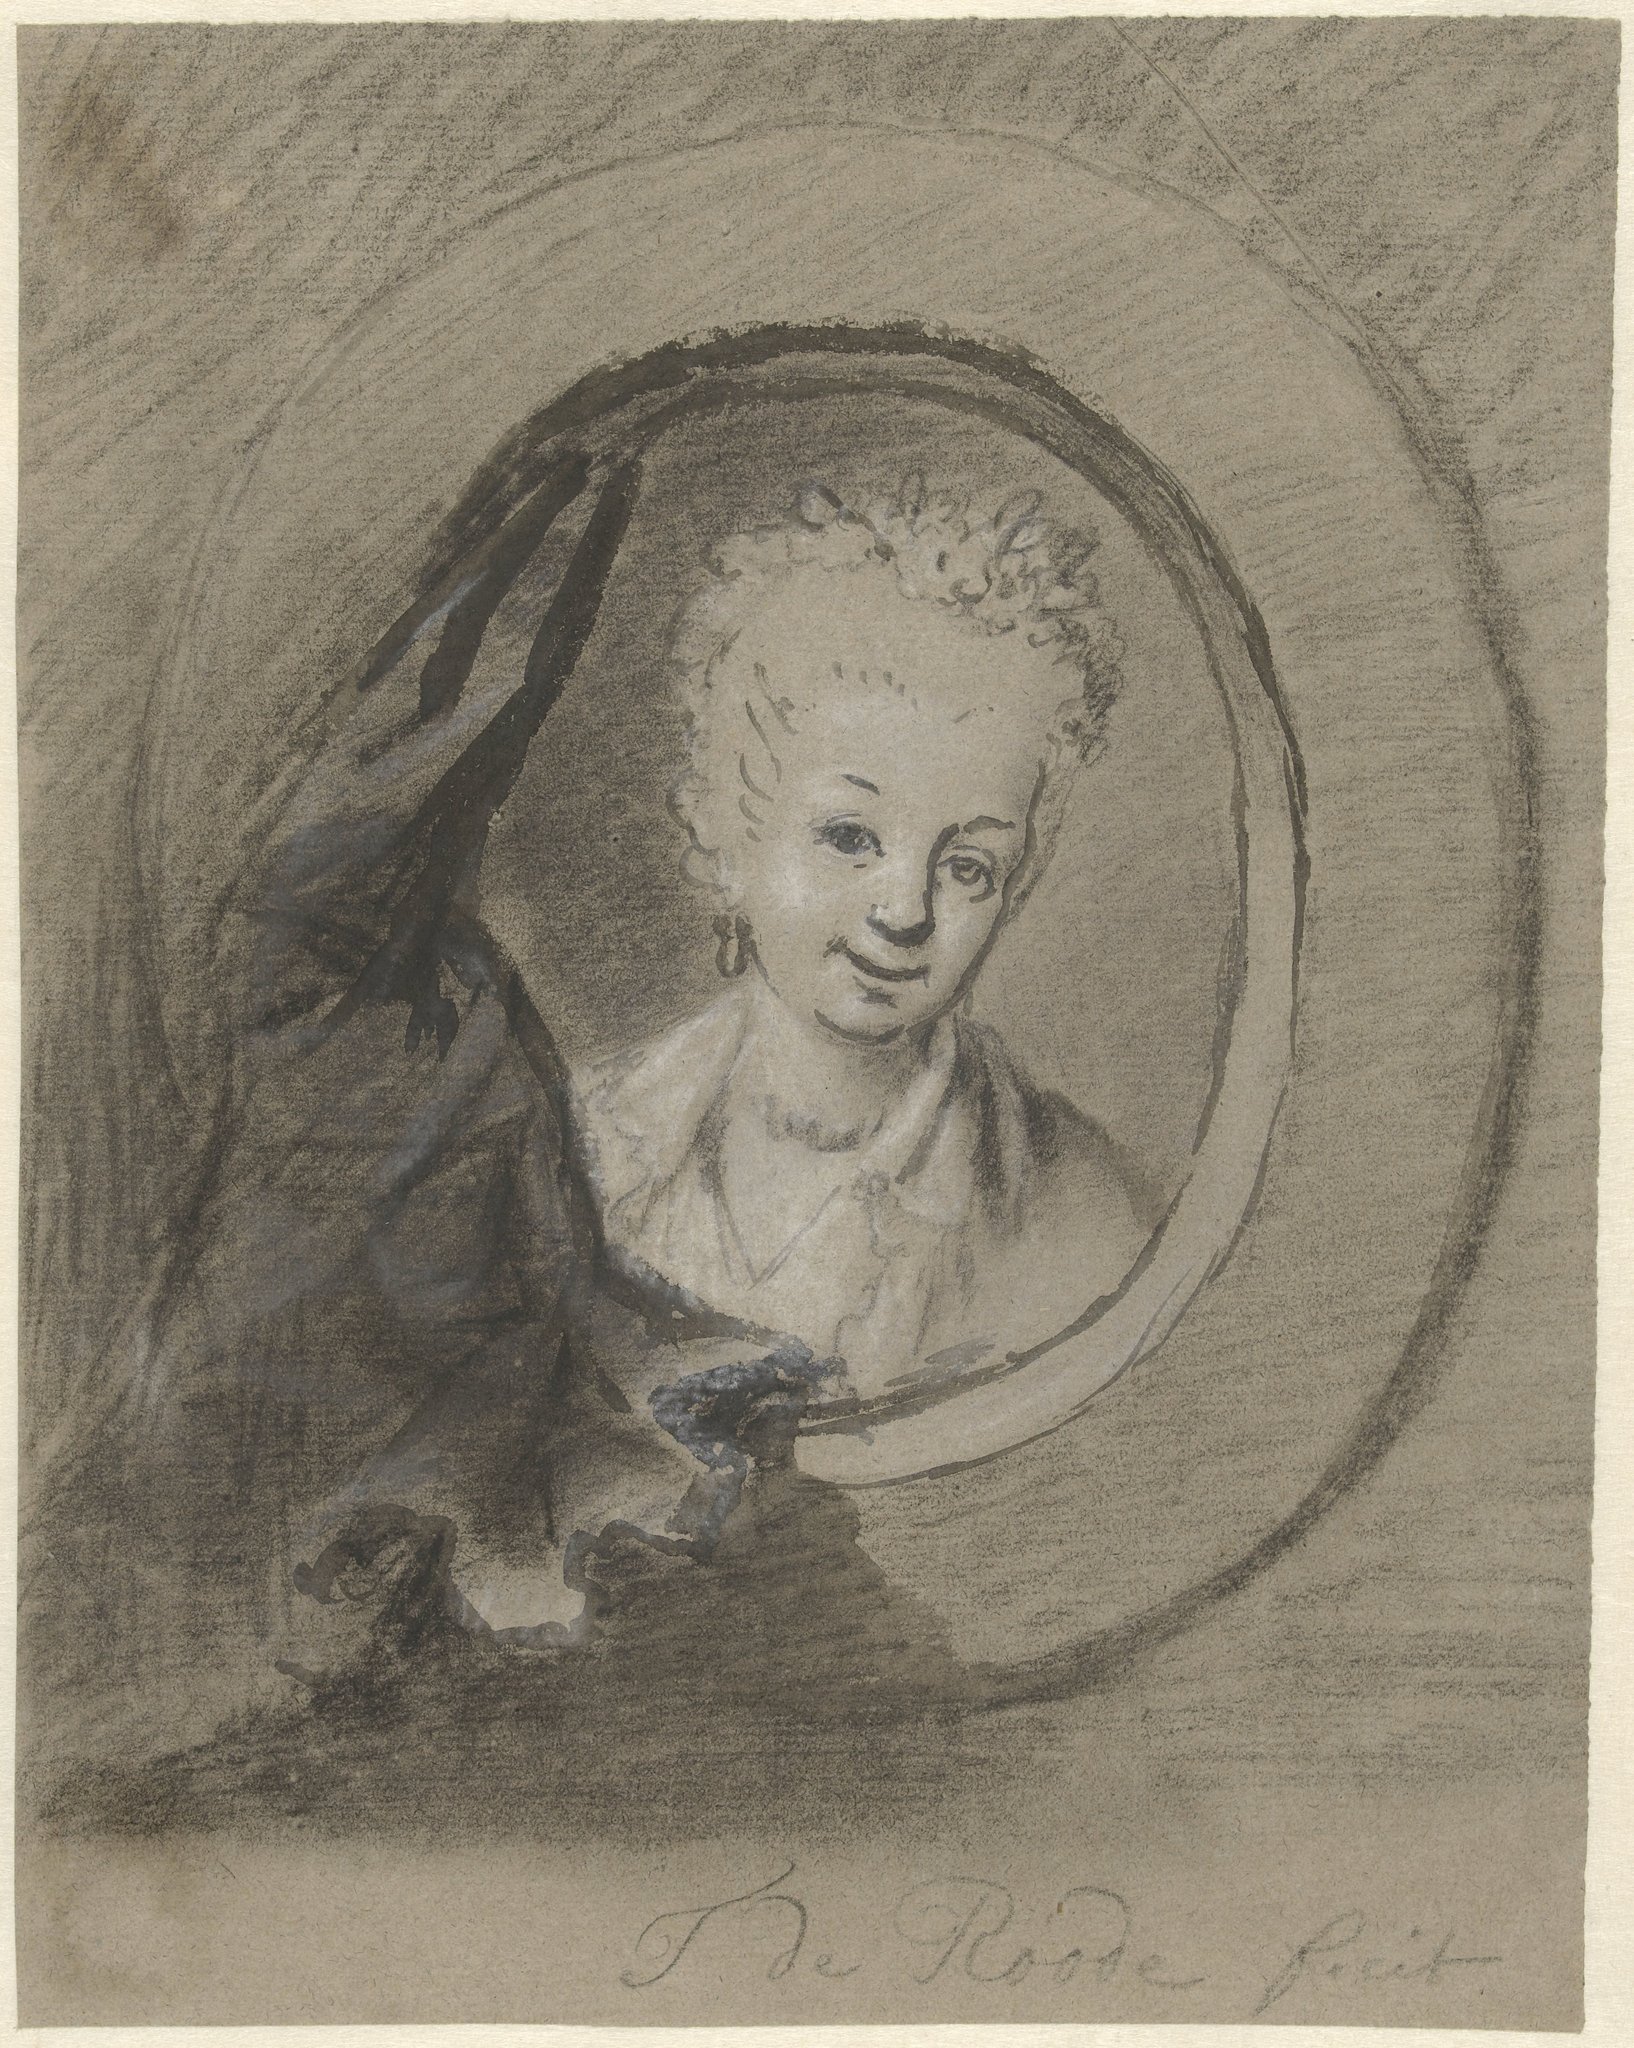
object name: drawing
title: Portret van een vrouw, in een ovale lijst met gordijntje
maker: theodorus de roode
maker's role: draughtsman, print maker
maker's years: 1736-1793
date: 1746-1793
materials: chalk, paper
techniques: brush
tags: anonymous historical person portrayed alone